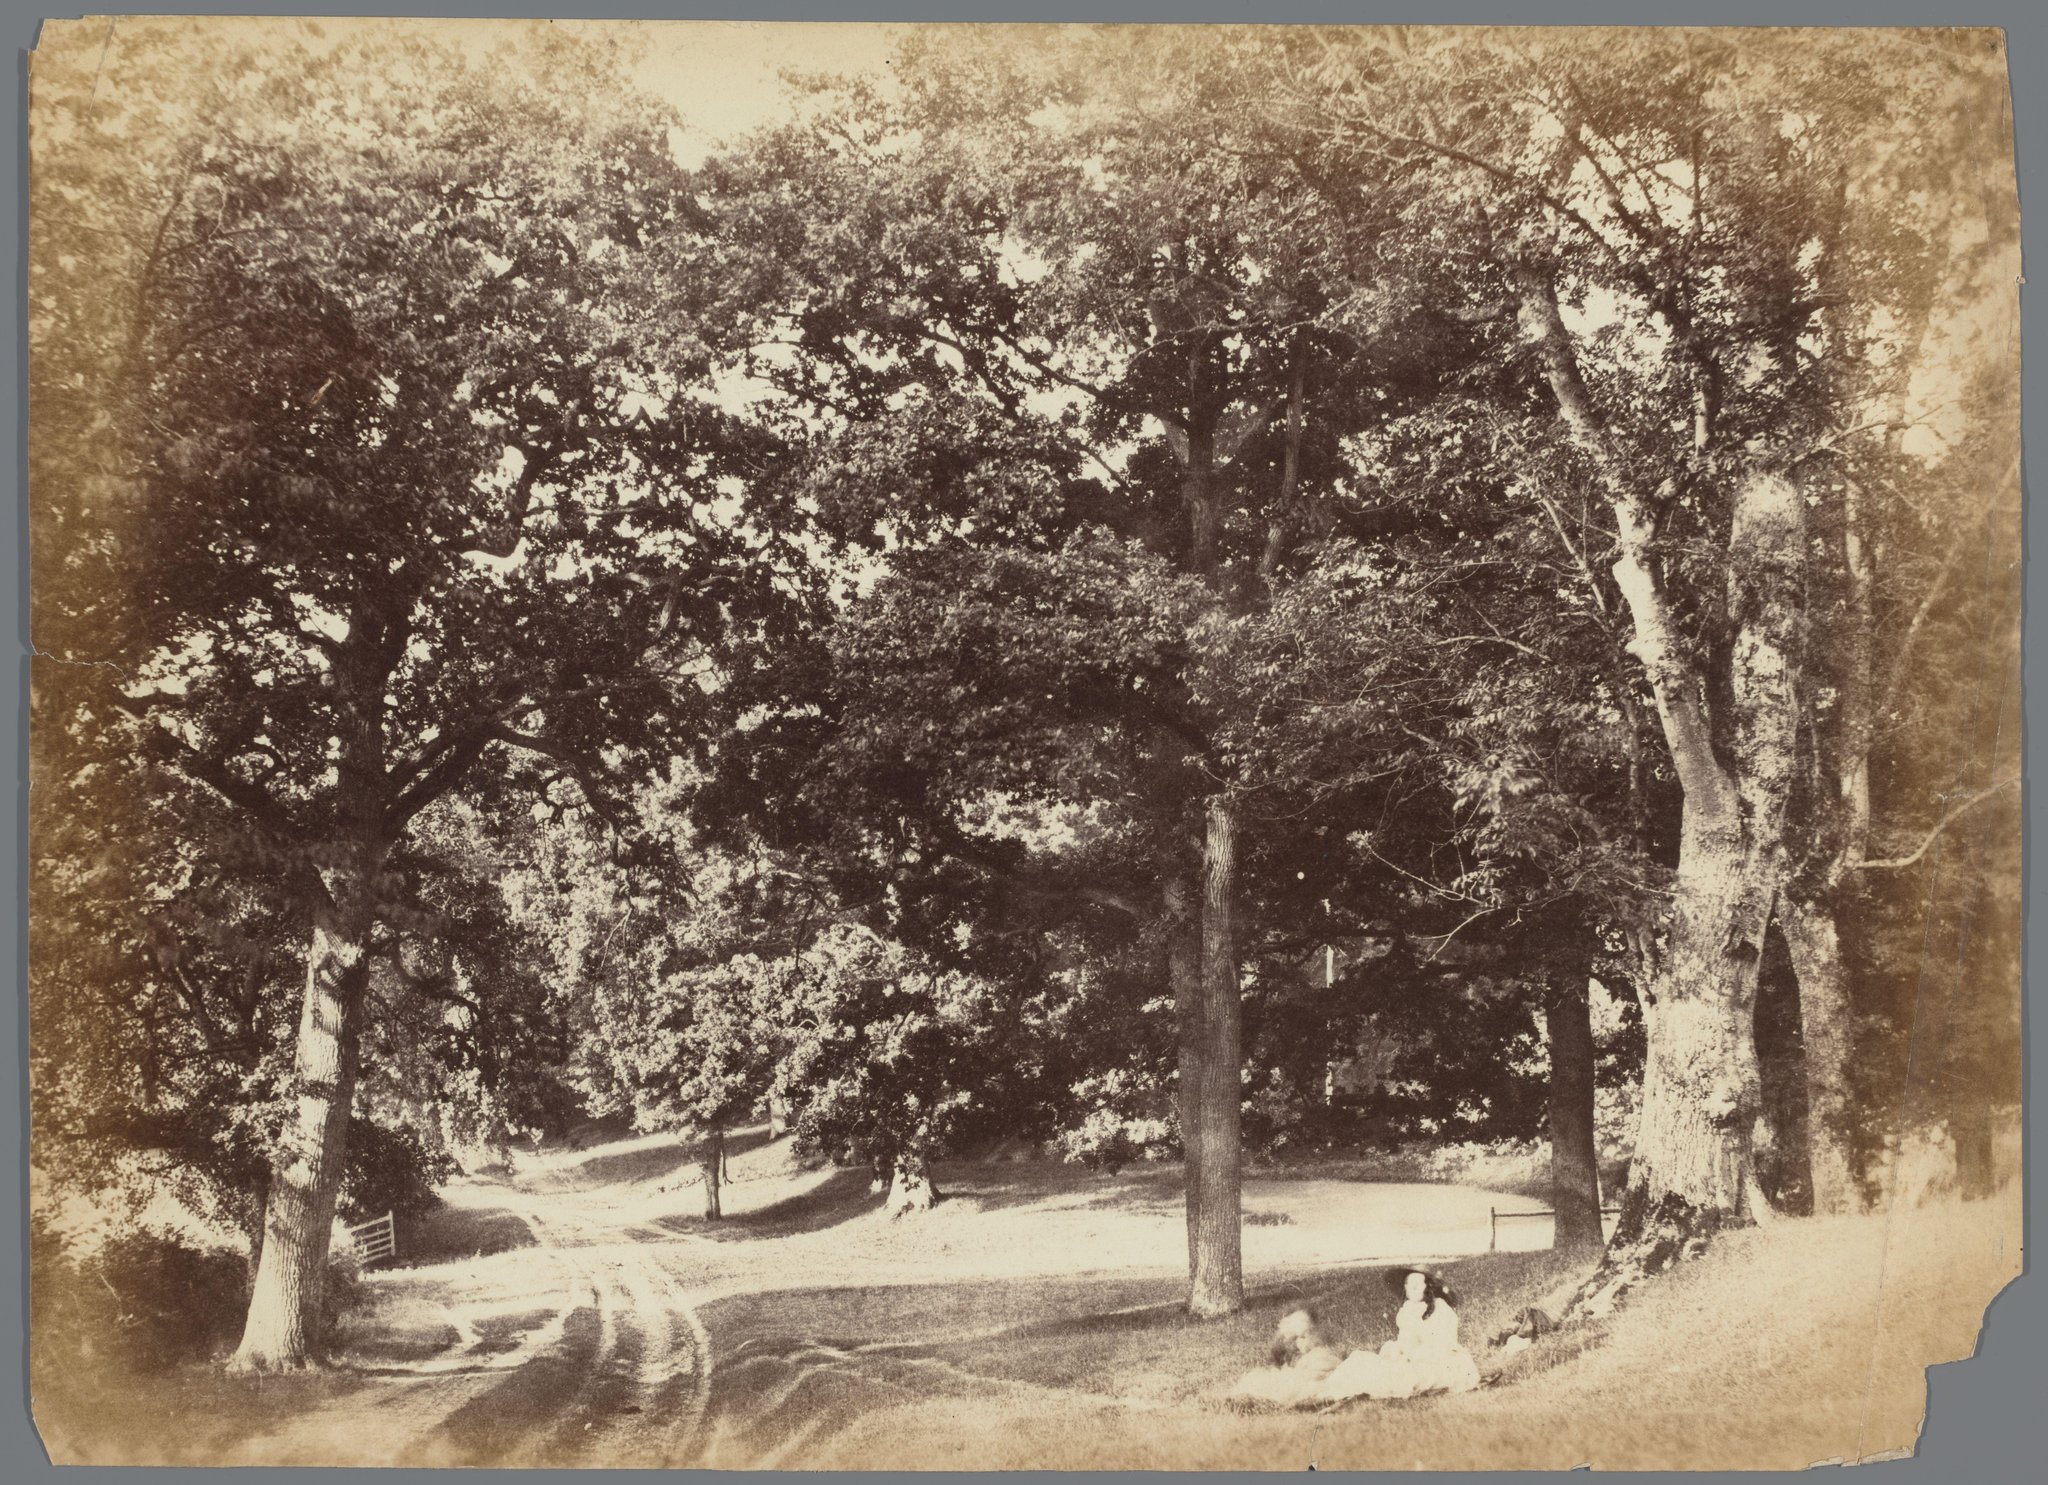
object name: photograph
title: Gezicht in bos/park, Engeland [?]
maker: Anonymous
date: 1855-1865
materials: photographic support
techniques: albumen print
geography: england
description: Gezicht in bos of park, met hoge bomen, en op de voorgrond een tweetal meisjes dat in het gras zit.